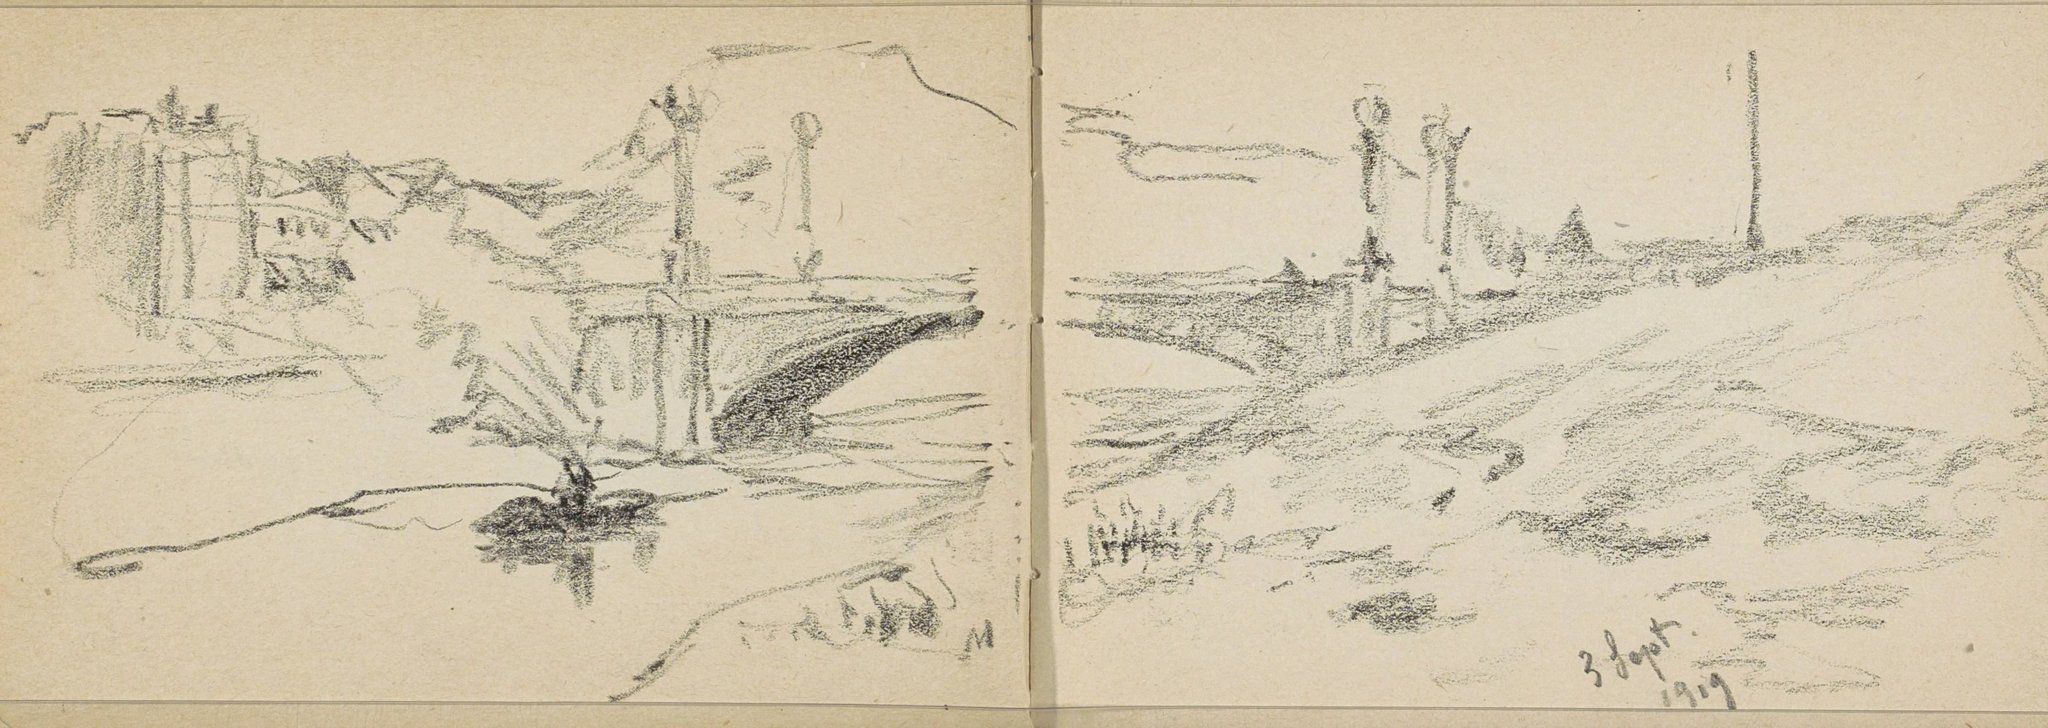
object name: sketchbook leaf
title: Brug over een kanaal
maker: willem cornelis rip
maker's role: draughtsman, painter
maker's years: 1856-1922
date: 1909-1919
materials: chalk, paper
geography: katwijk aan zee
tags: city-view, and landscape with man-made constructions, canals, waters (in city), bridge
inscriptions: date: ‘3 Sept/ 1919’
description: Mogelijk het Prins Hendrikkanaal te Katwijk-aan-Zee. Blad 2 verso en 3 recto uit een schetsboek met 42 bladen.